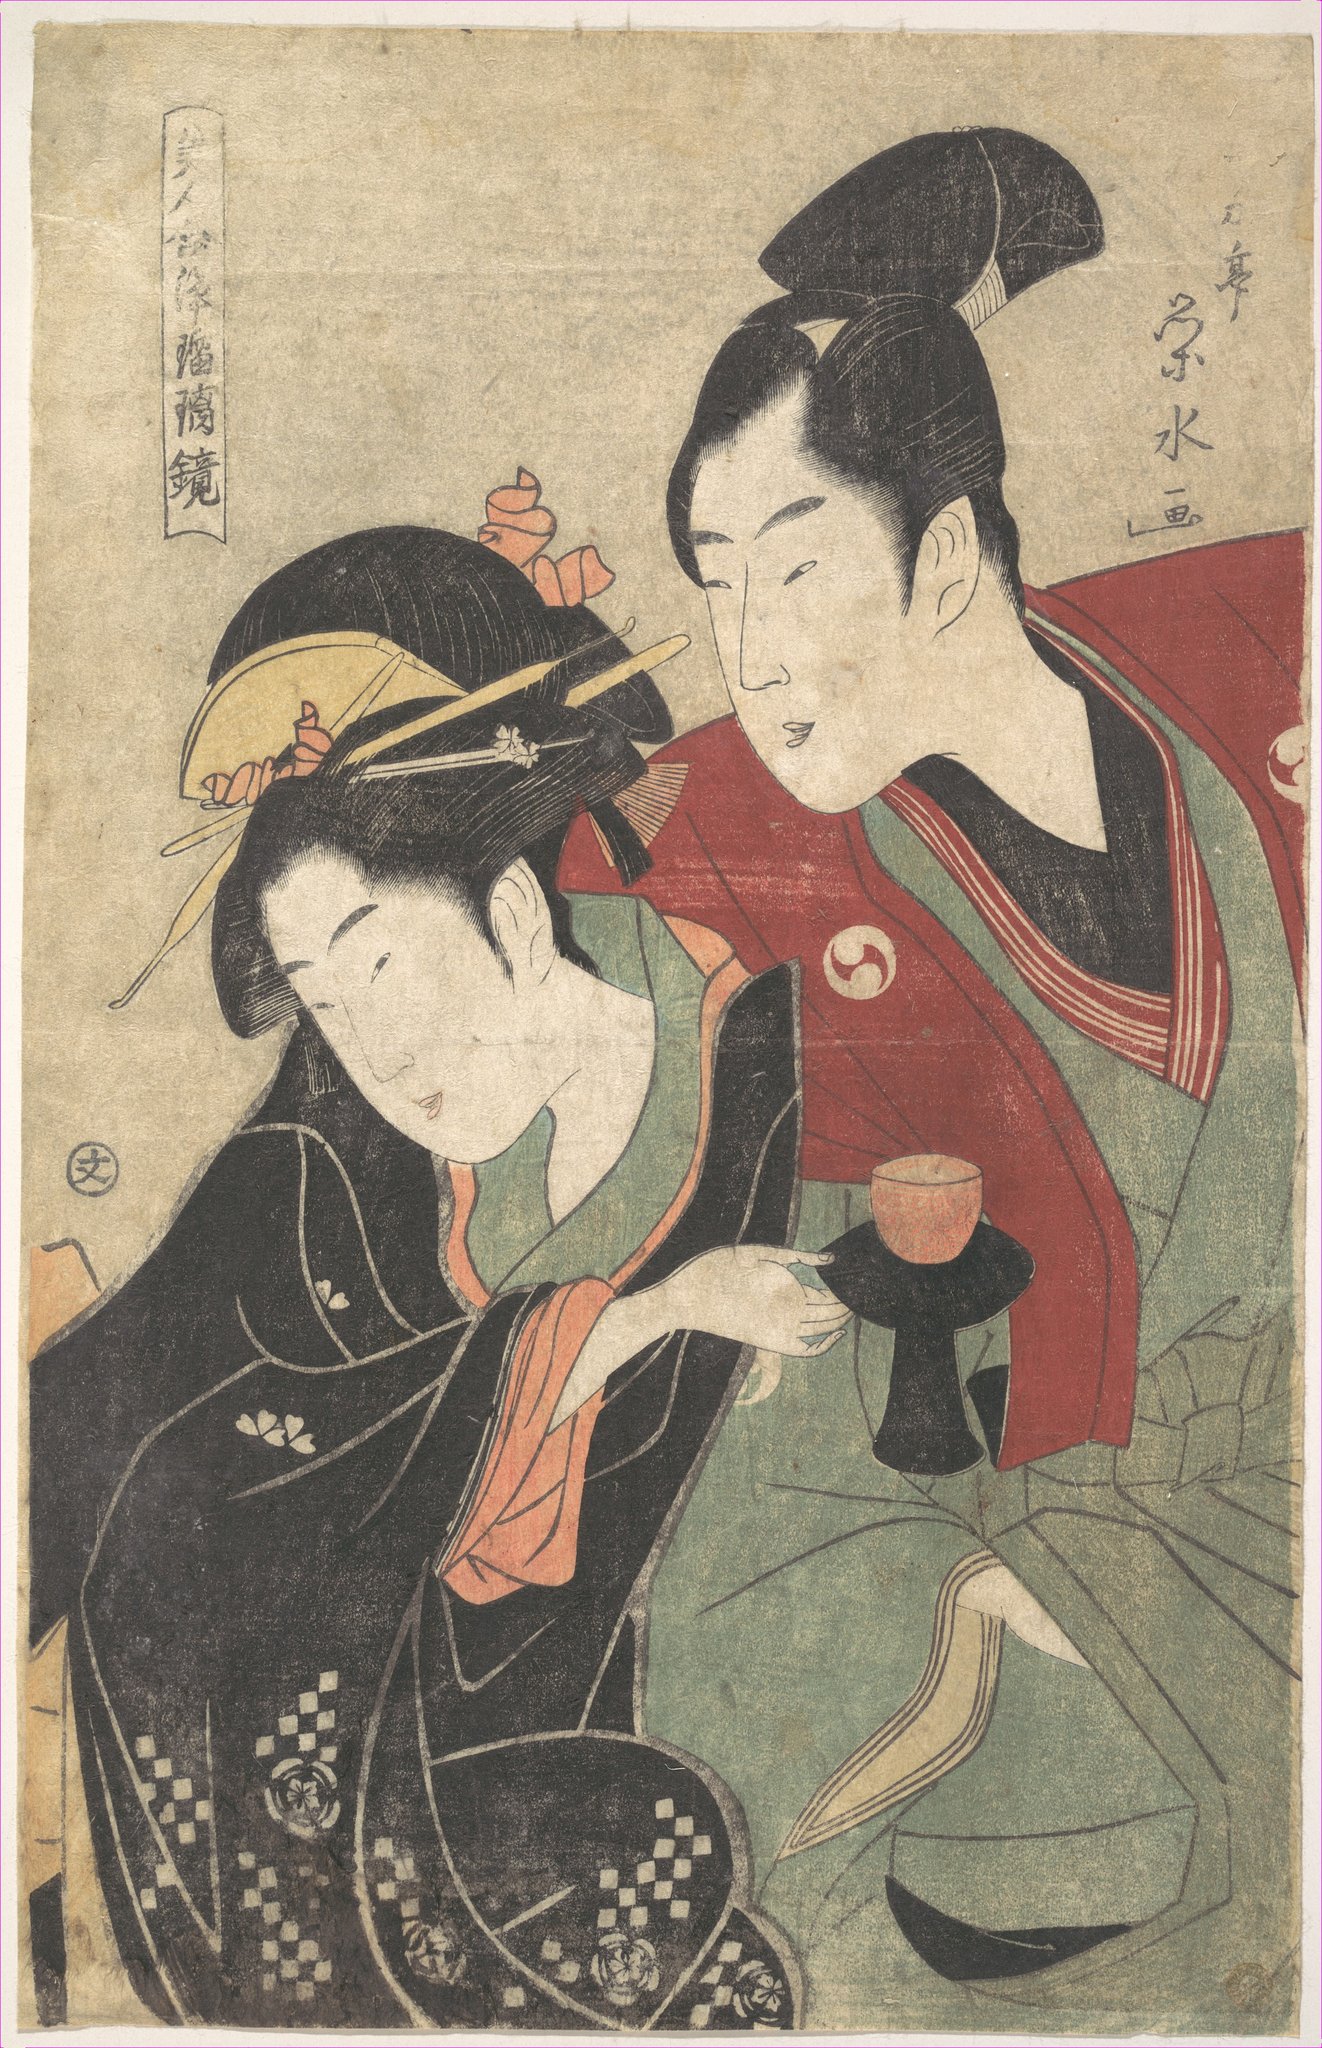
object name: woodblock print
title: Scene from the "Chushingura" Drama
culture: japanese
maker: ichirakutei eisui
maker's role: artist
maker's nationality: japanese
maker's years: 1793-1801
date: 1797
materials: ink, paper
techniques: woodblock print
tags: men,women